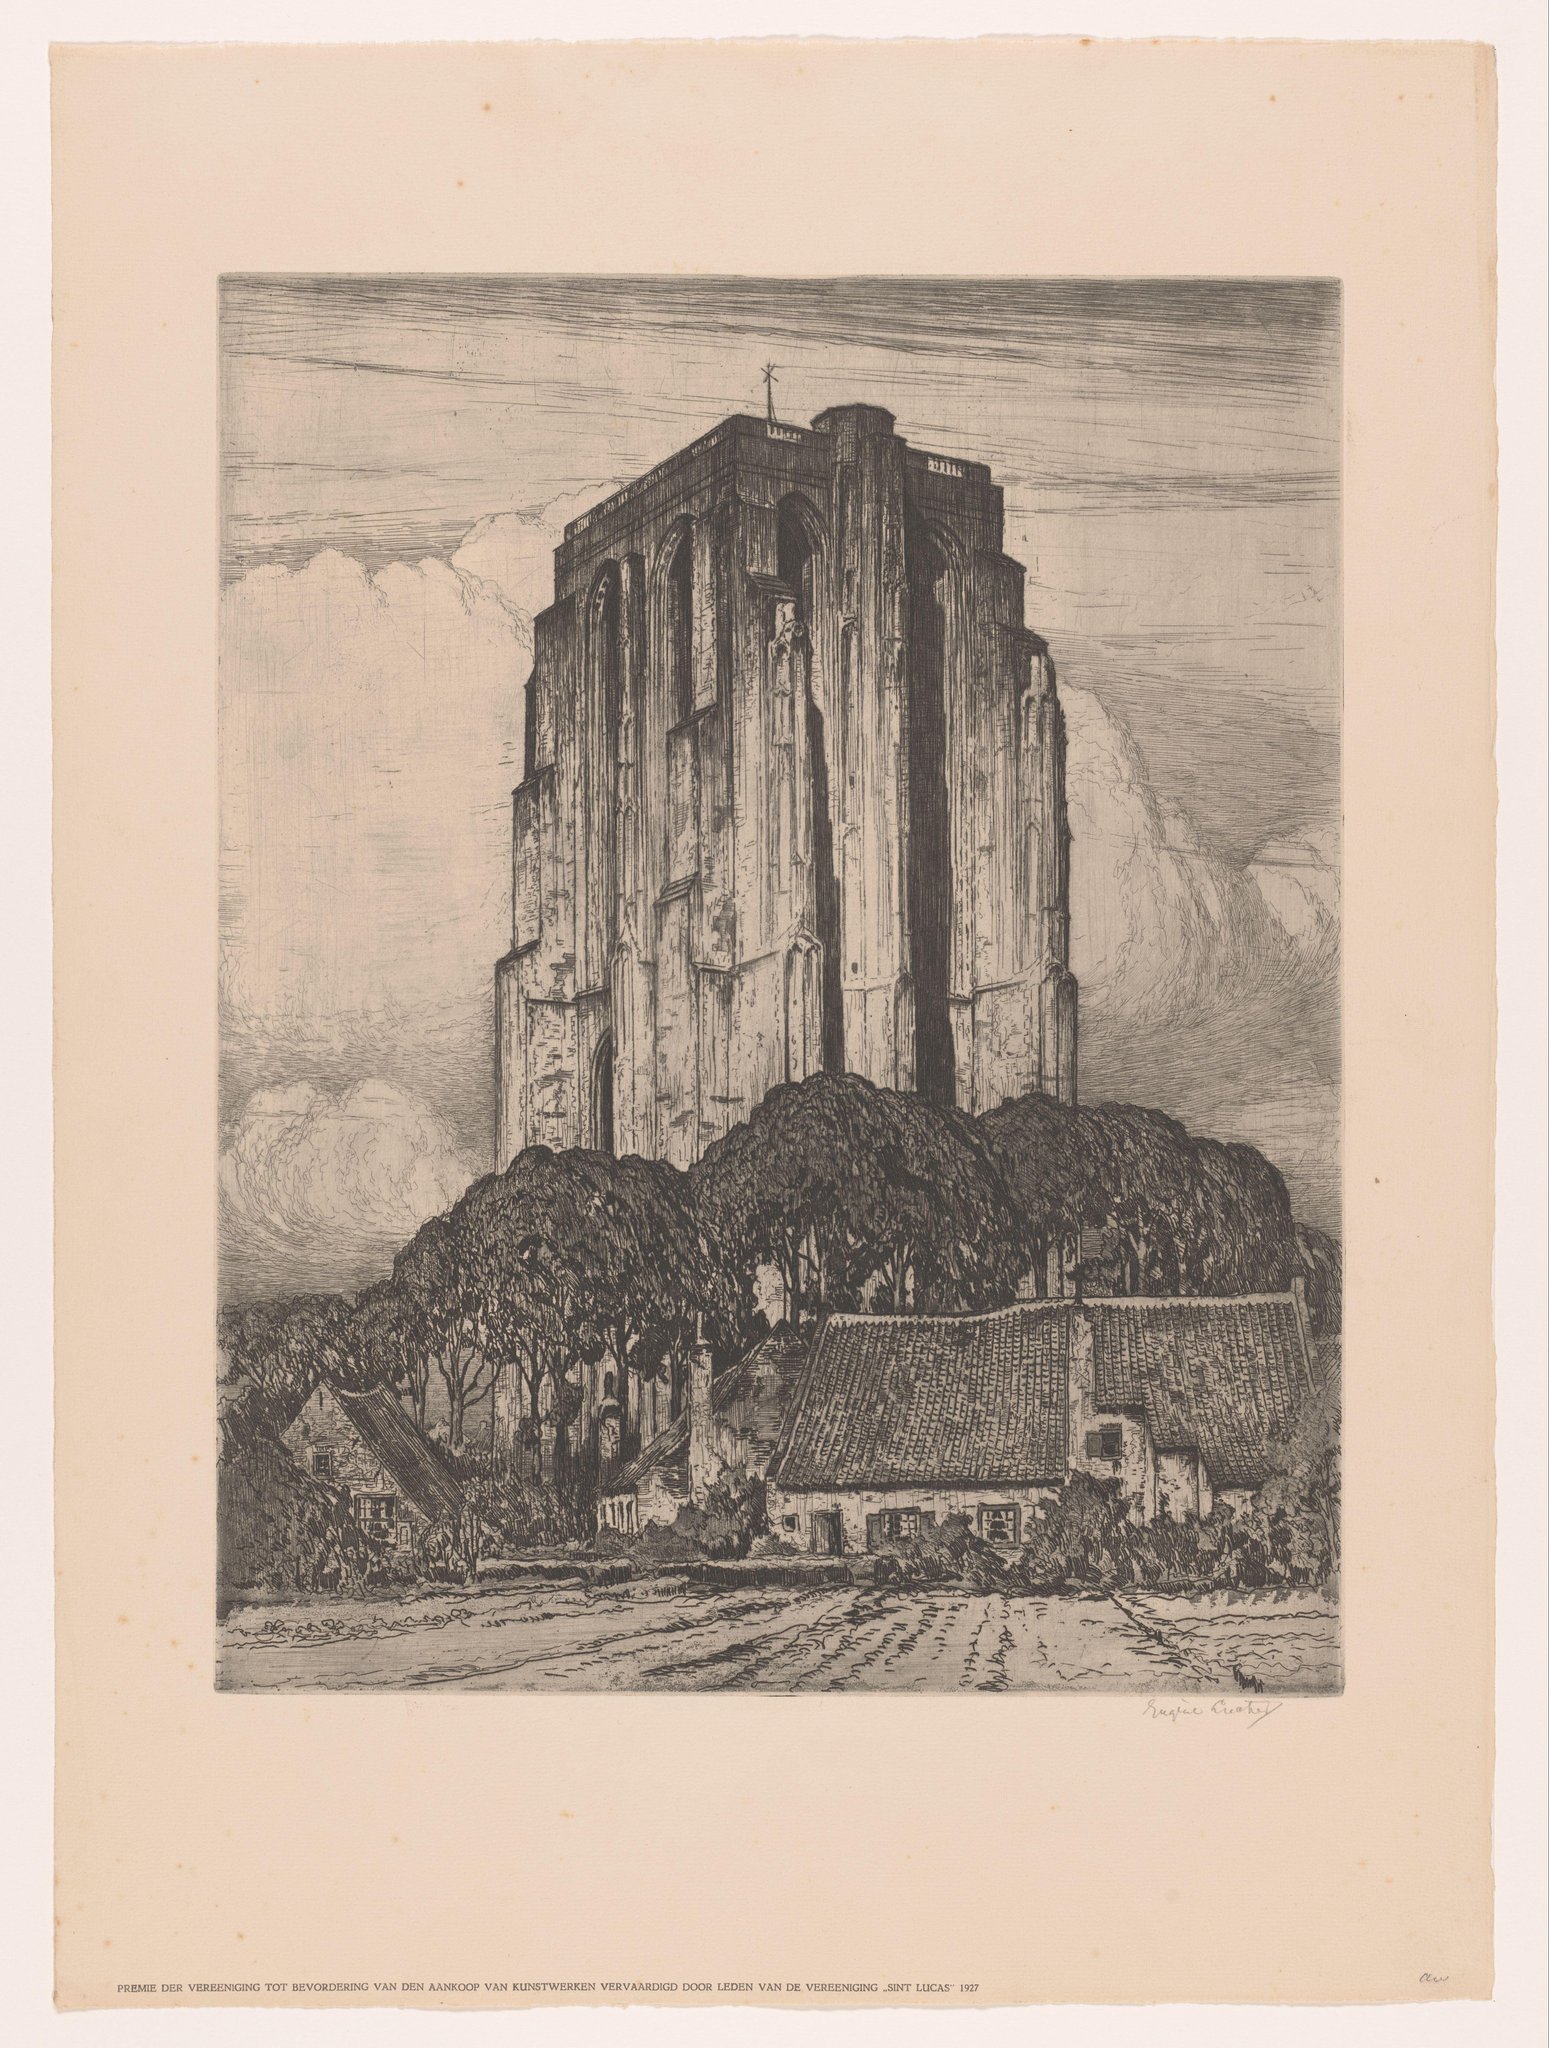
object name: print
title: Gezicht op de Sint-Lievensmonstertoren te Zierikzee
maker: eugène lücker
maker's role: print maker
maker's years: 1876-1943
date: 1927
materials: paper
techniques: drypoint, etching, intaglio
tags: church (exterior)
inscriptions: inscription: ‘Premie der Vereeniging tot Bevordering van den aankoop van kunstwerken vervaardigd door leden van de vereeniging "Sint Lucas" 1927’, collector's mark: Lugt 2228